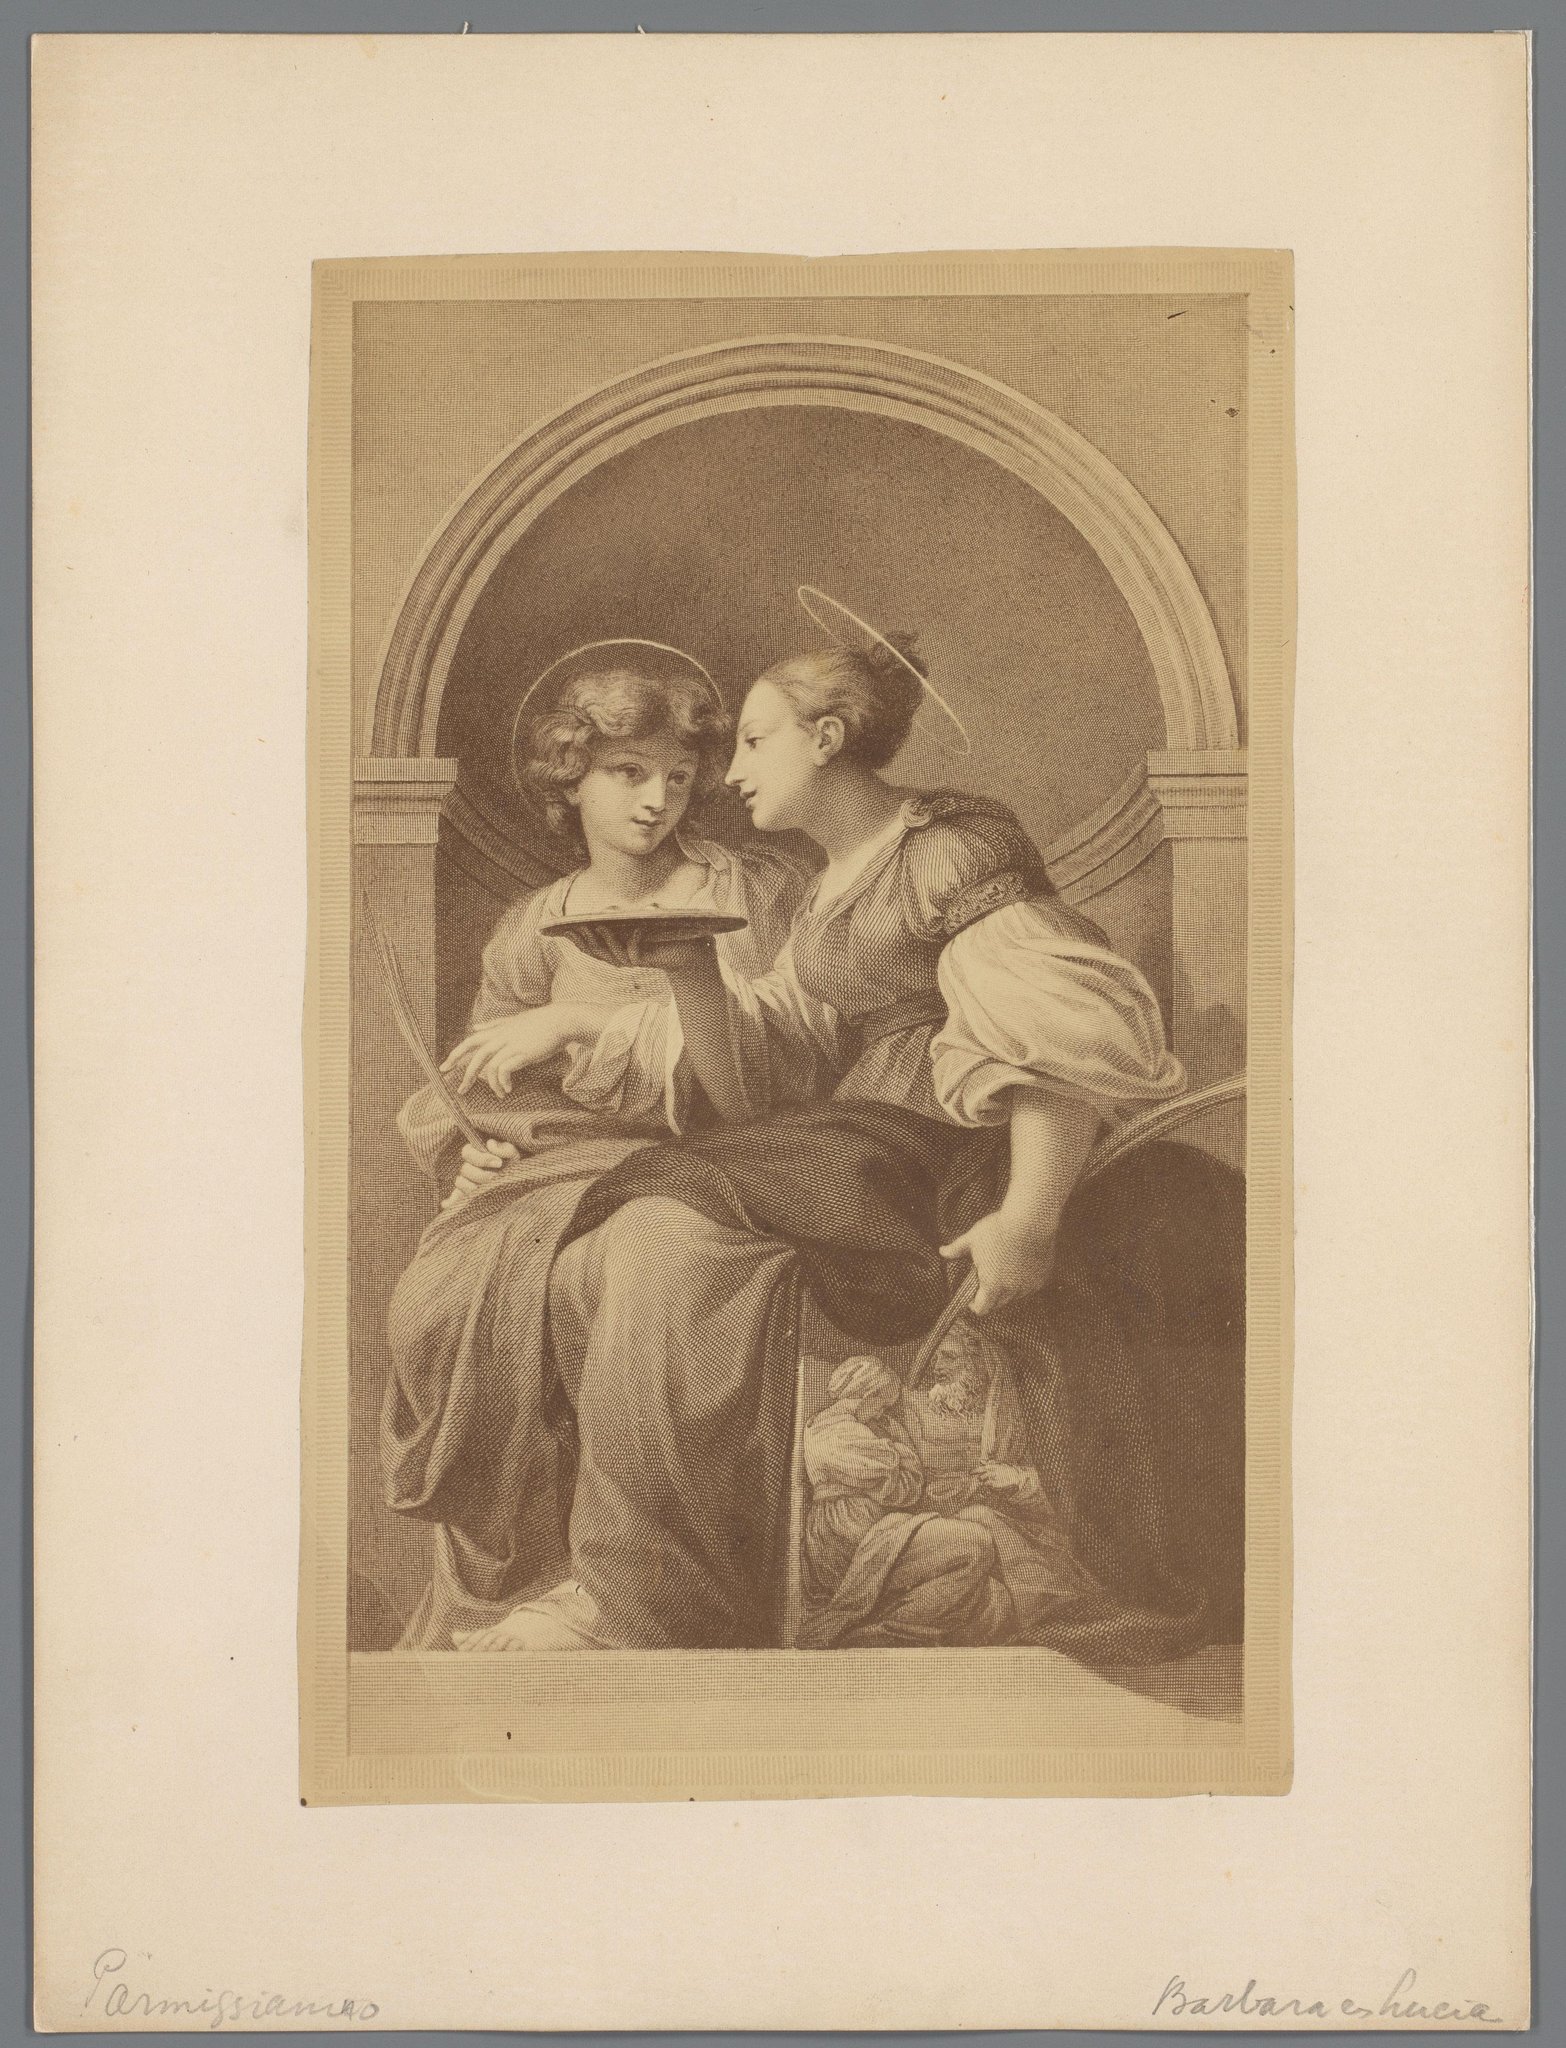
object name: photograph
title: Fotoreproductie van een prent van de heilige Barbara en Lucia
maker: Anonymous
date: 1860-1900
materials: cardboard, paper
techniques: albumen print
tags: the virgin martyr barbara; possible attributes: book, cannon(ball), crown, cross, chalice with wafer, dioscuros (her father), peacock feather, sword, torches, mason's tools, tower, the virgin martyr lucy (lucia) of syracuse; possible attributes: dagger or sword (in neck), eyes, flames at feet, lamp, ox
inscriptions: inscription: ‘Parmissiamo/ Barbara en Lucia’, stamp: Lugt 3937